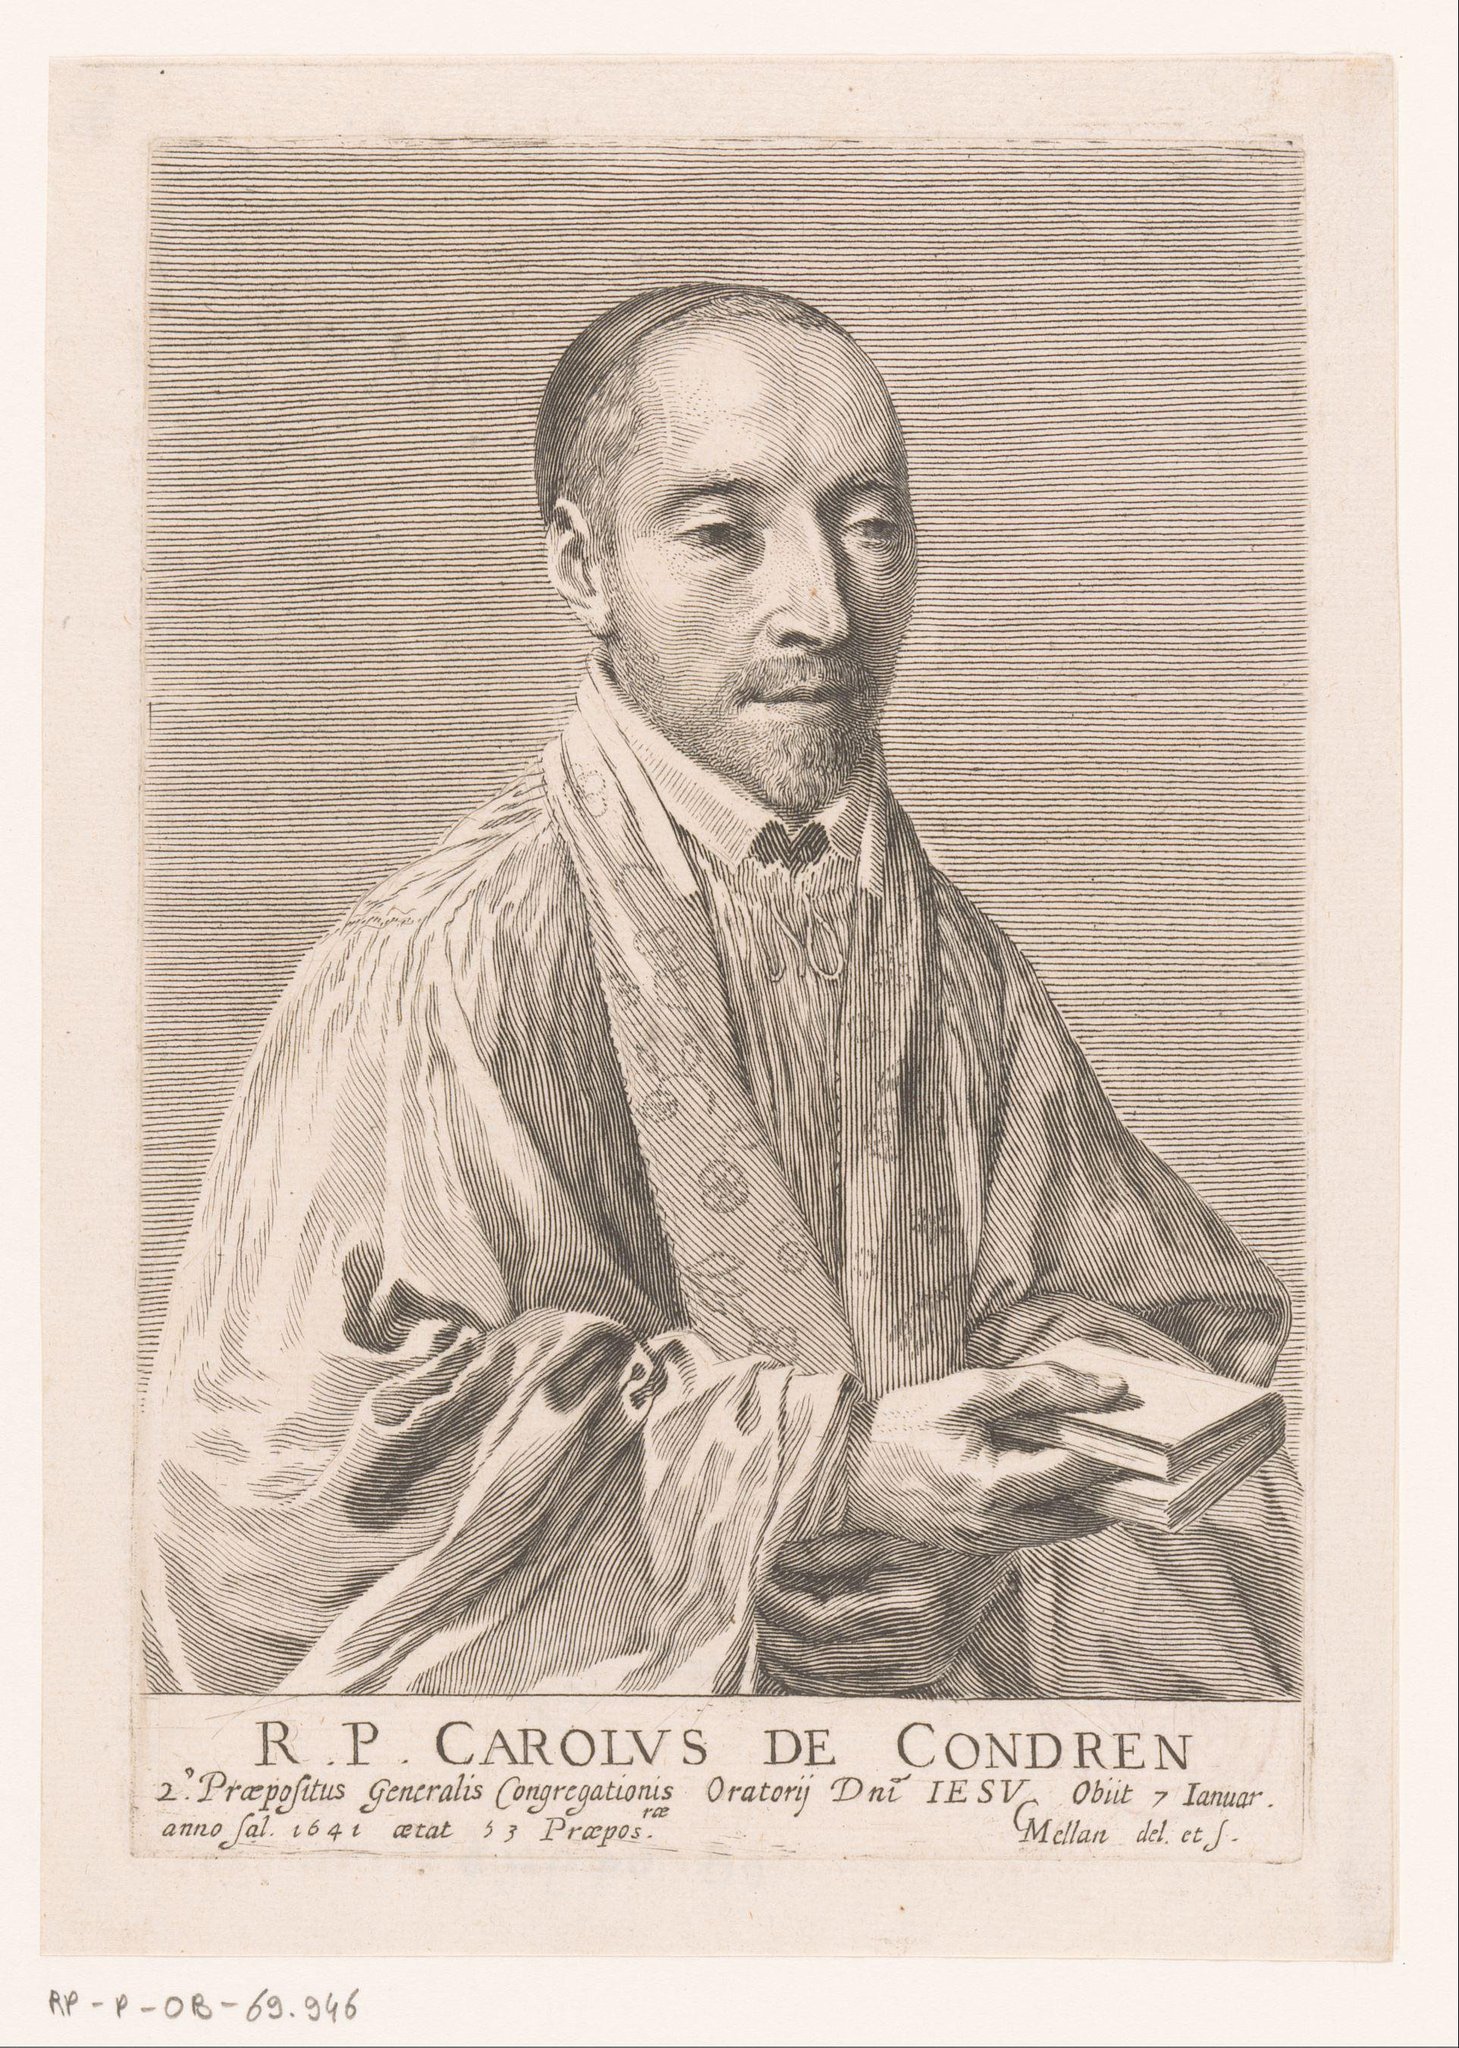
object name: print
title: R.P. Carolus De Condren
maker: claude mellan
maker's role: draughtsman, print maker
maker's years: 1598-1688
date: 1641-1688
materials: paper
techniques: engraving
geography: france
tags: historical persons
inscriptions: collector's mark: Lugt 240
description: Er bestaan drie voorbereidende tekeningen: één in het Musée des Beaux-Arts te Besançon; een ander in een particuliere collectie in Parijs en de laatste in de Hermitage te Sint-Petersburg, inv.nr. 4611.